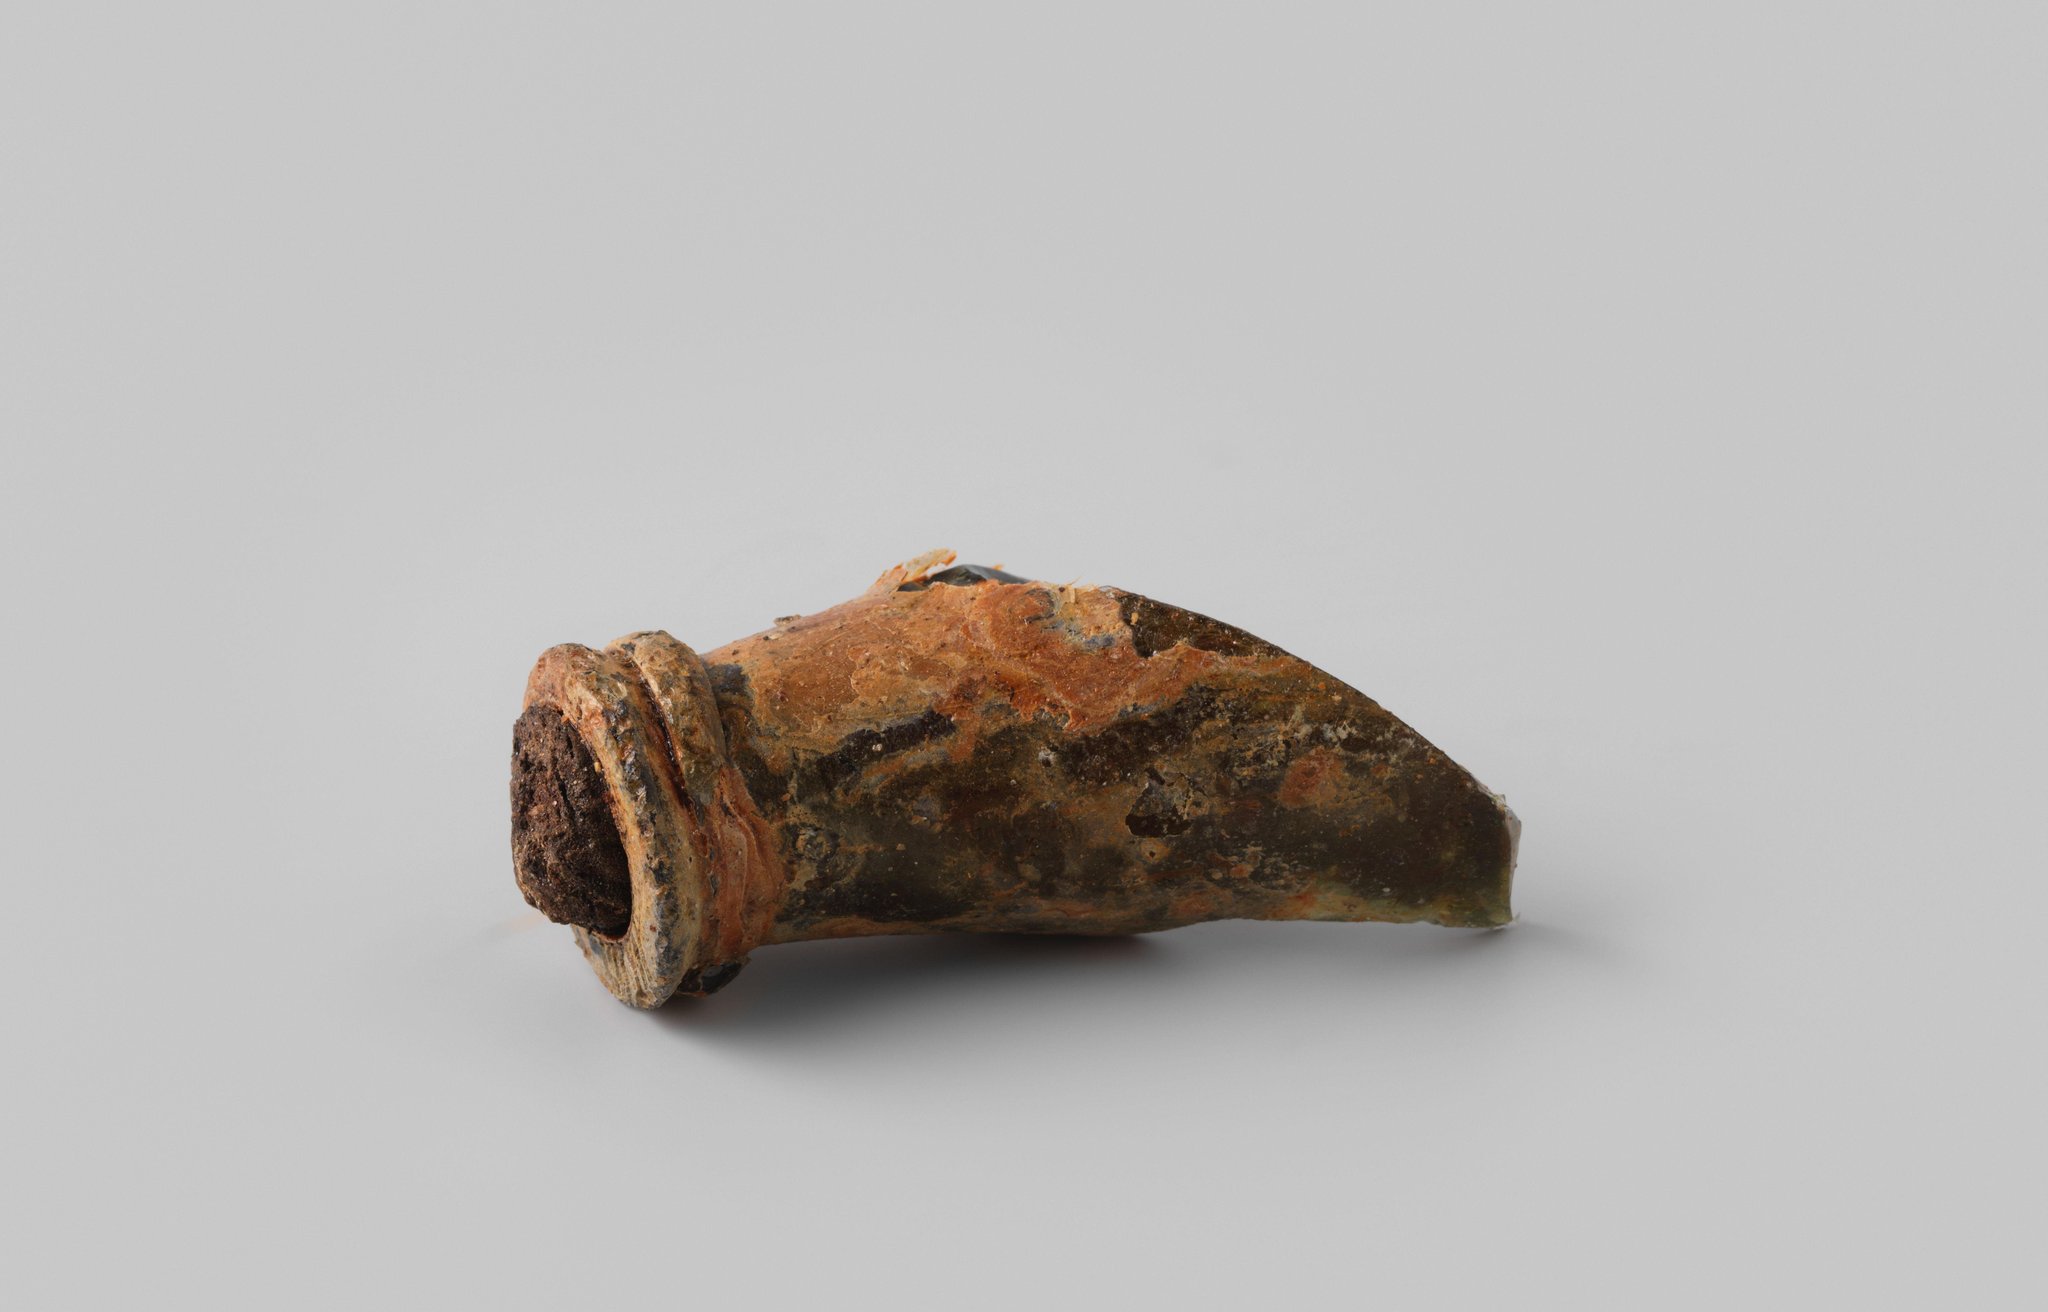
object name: wine bottle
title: Hals met kurk van een wijnfles uit het wrak van de Oost-Indiëvaarder Hollandia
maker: Anonymous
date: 1700-1743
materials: cork, glass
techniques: green glass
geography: netherlands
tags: verenigde oostindische compagnie, hollandia (schip), annet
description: Wine bottle, continental production, neck, onion-shaped bottle or bottle with vertical side; fragm, eroded, vs-string rim, projecting cork.